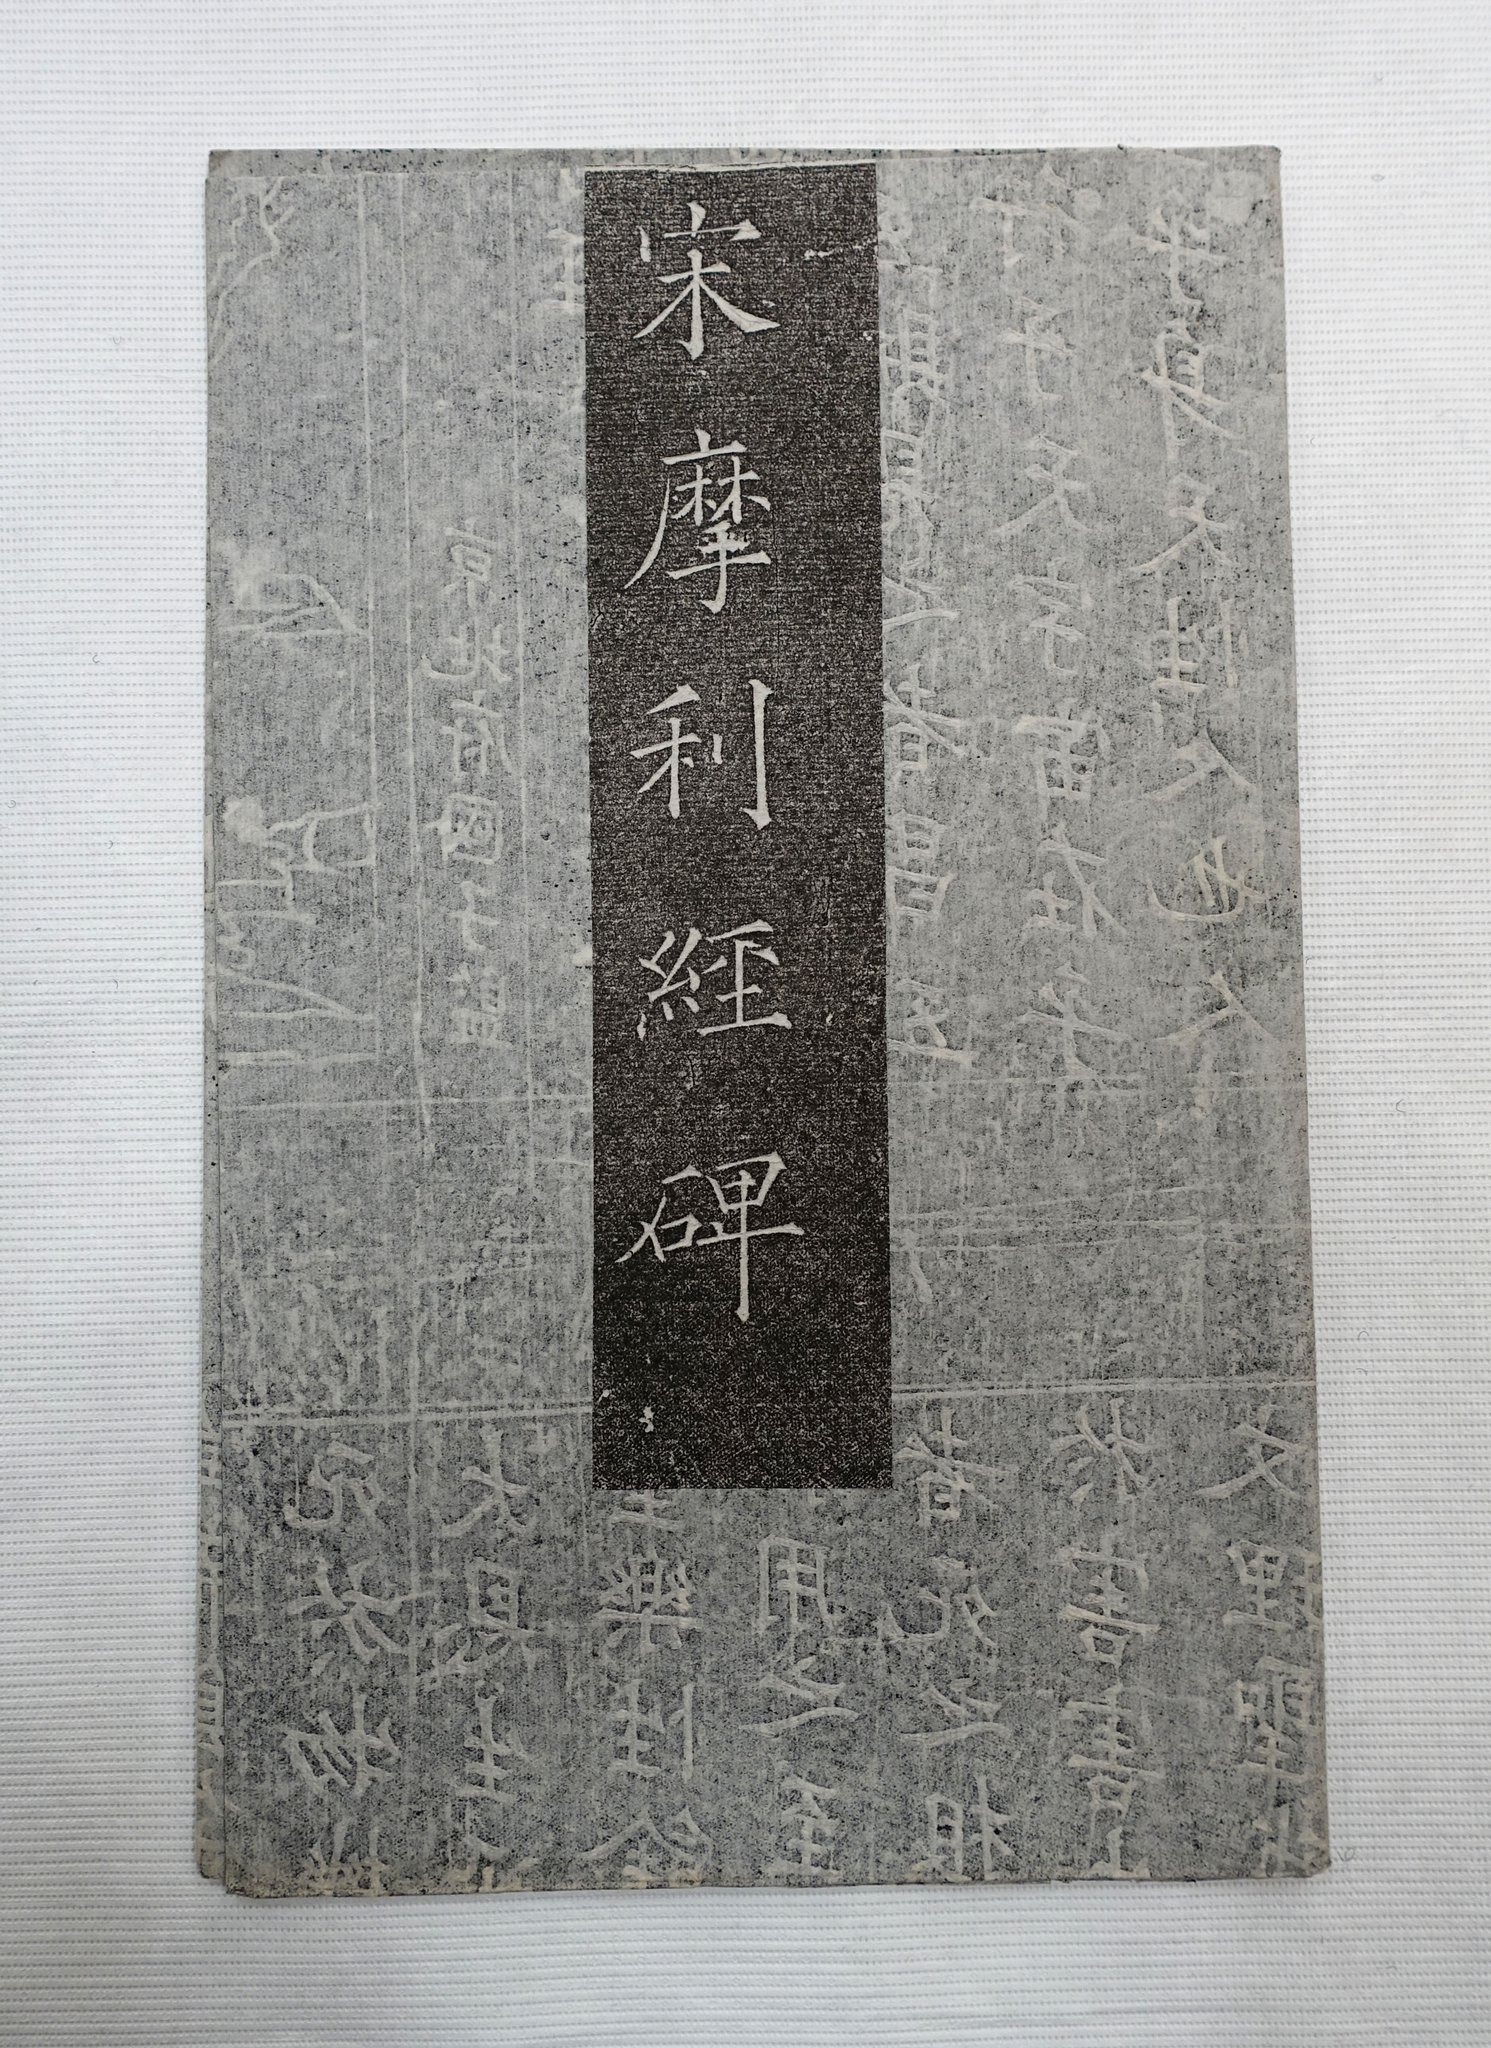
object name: rubbing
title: Marici Sutra and Yellow Emperor's Sutra for Secret Charm Against Evil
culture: chinese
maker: li fenggui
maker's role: artist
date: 1901-2000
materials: ink, paper